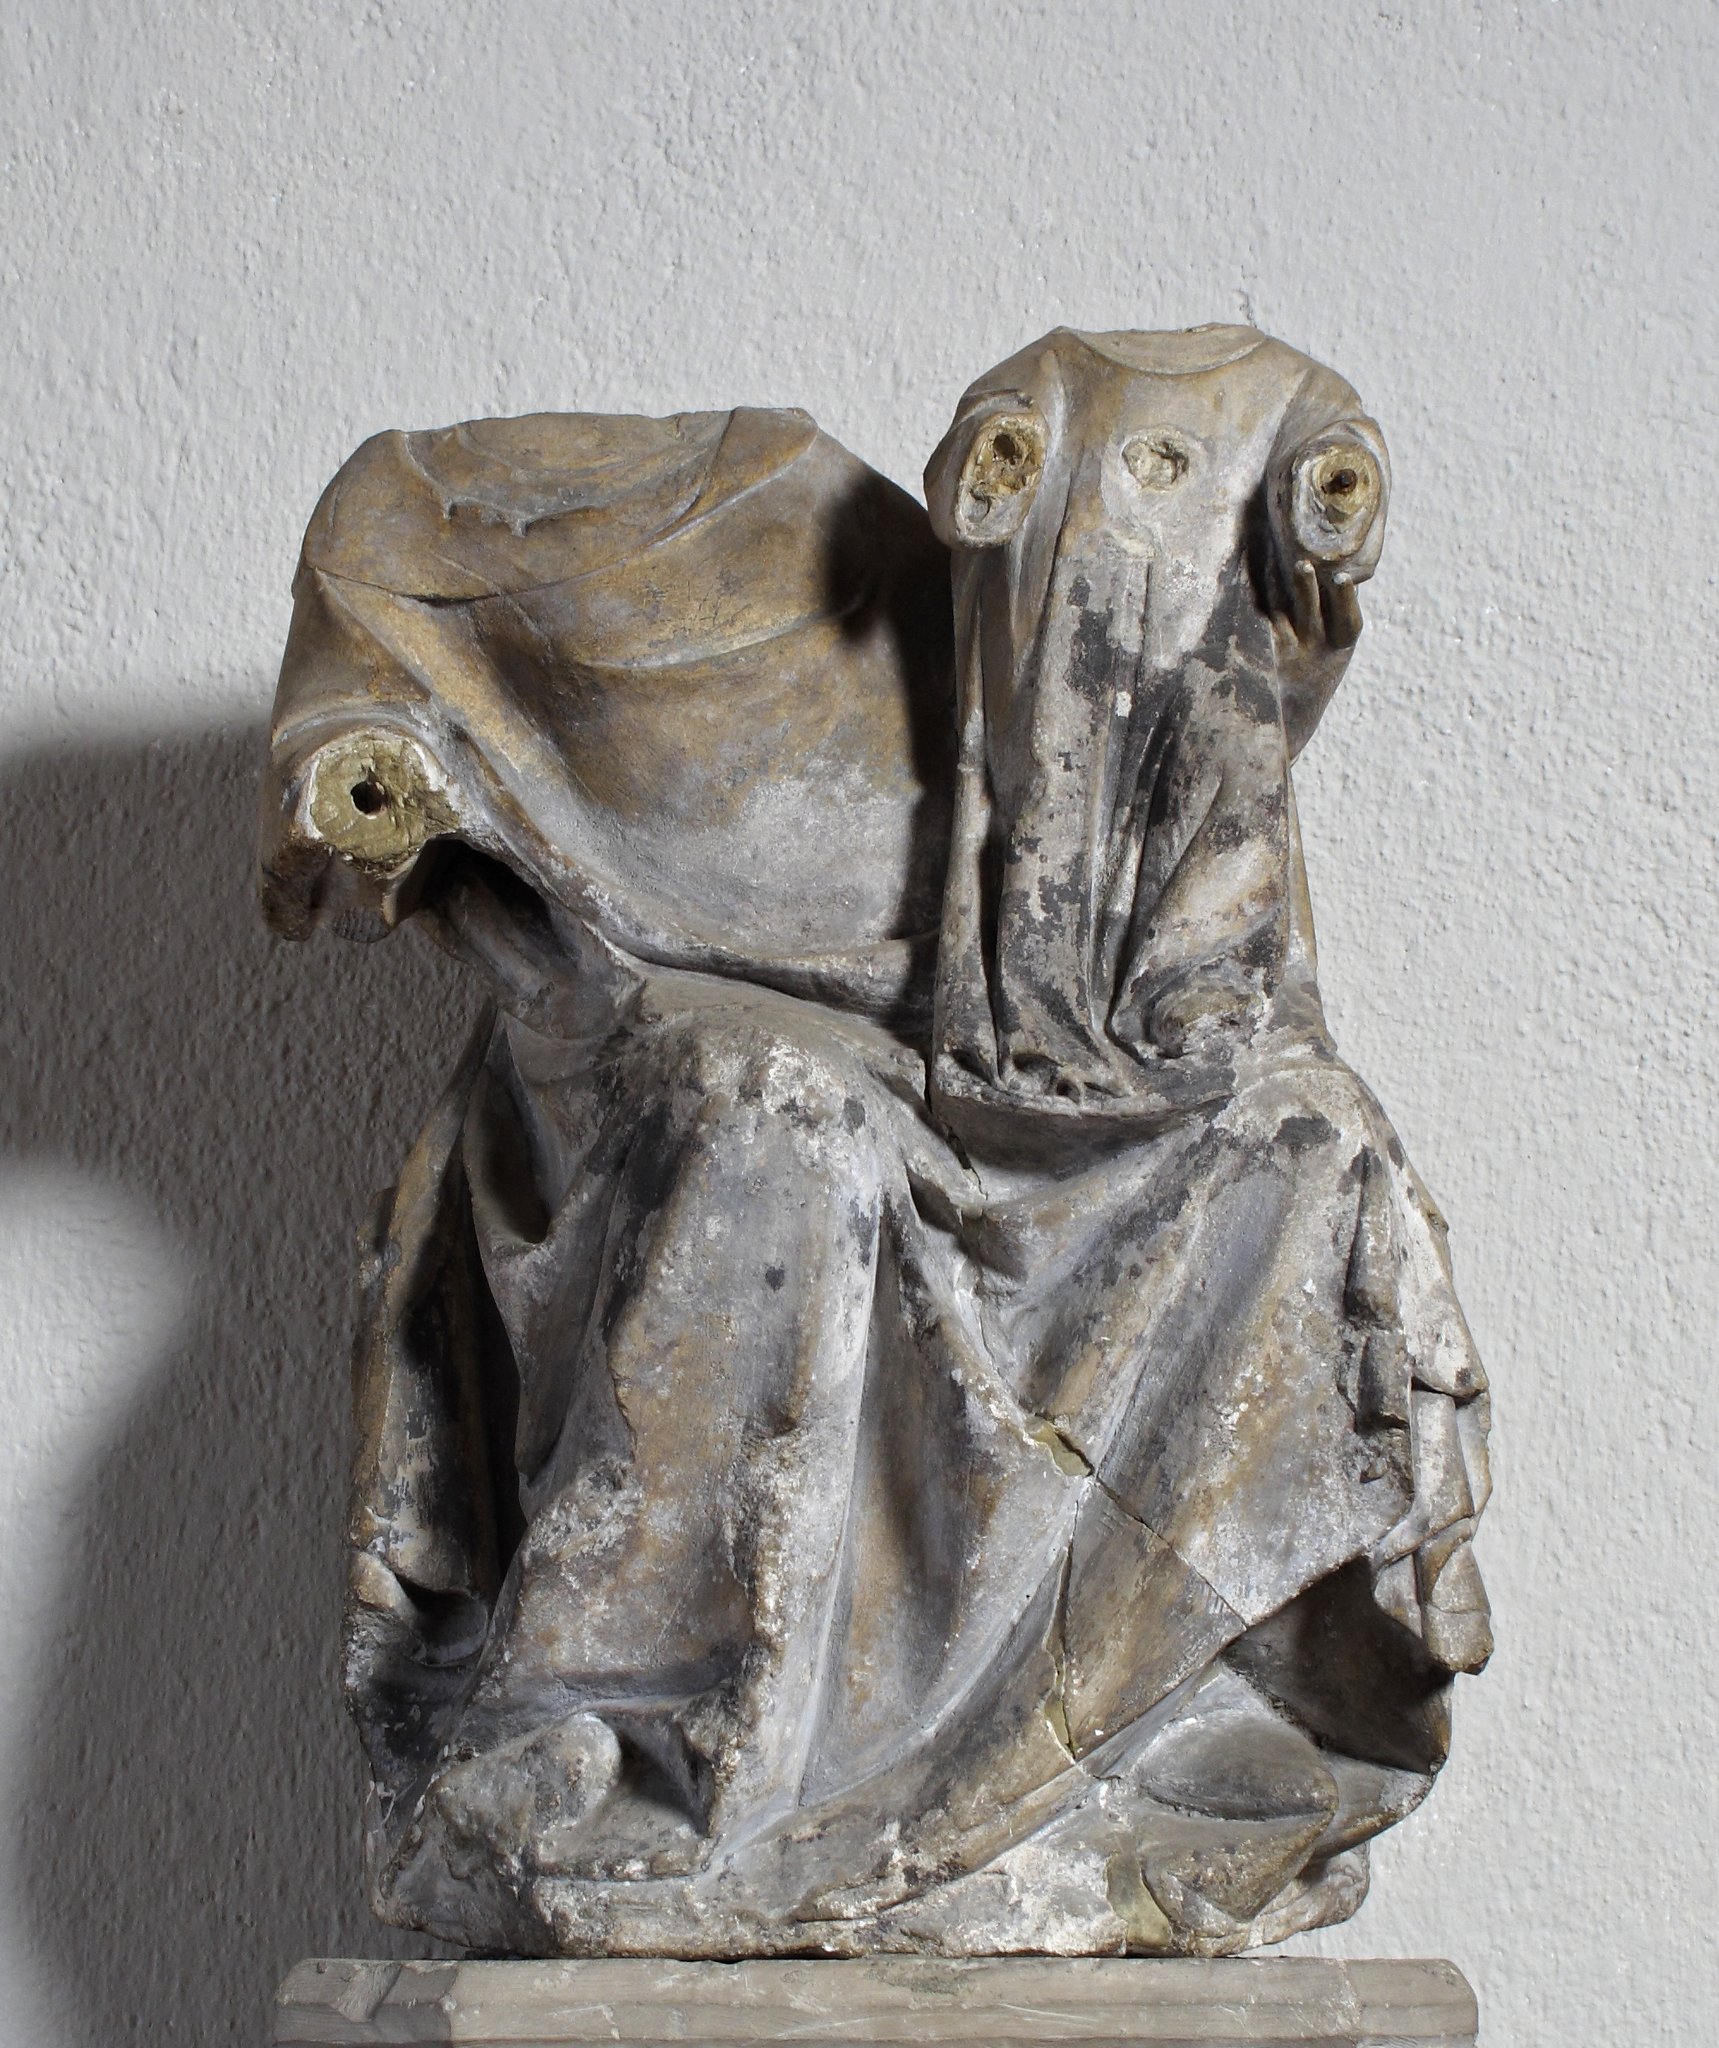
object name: statuette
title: Virgin and Child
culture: french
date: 1301-1400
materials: paint, stone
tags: madonna and child